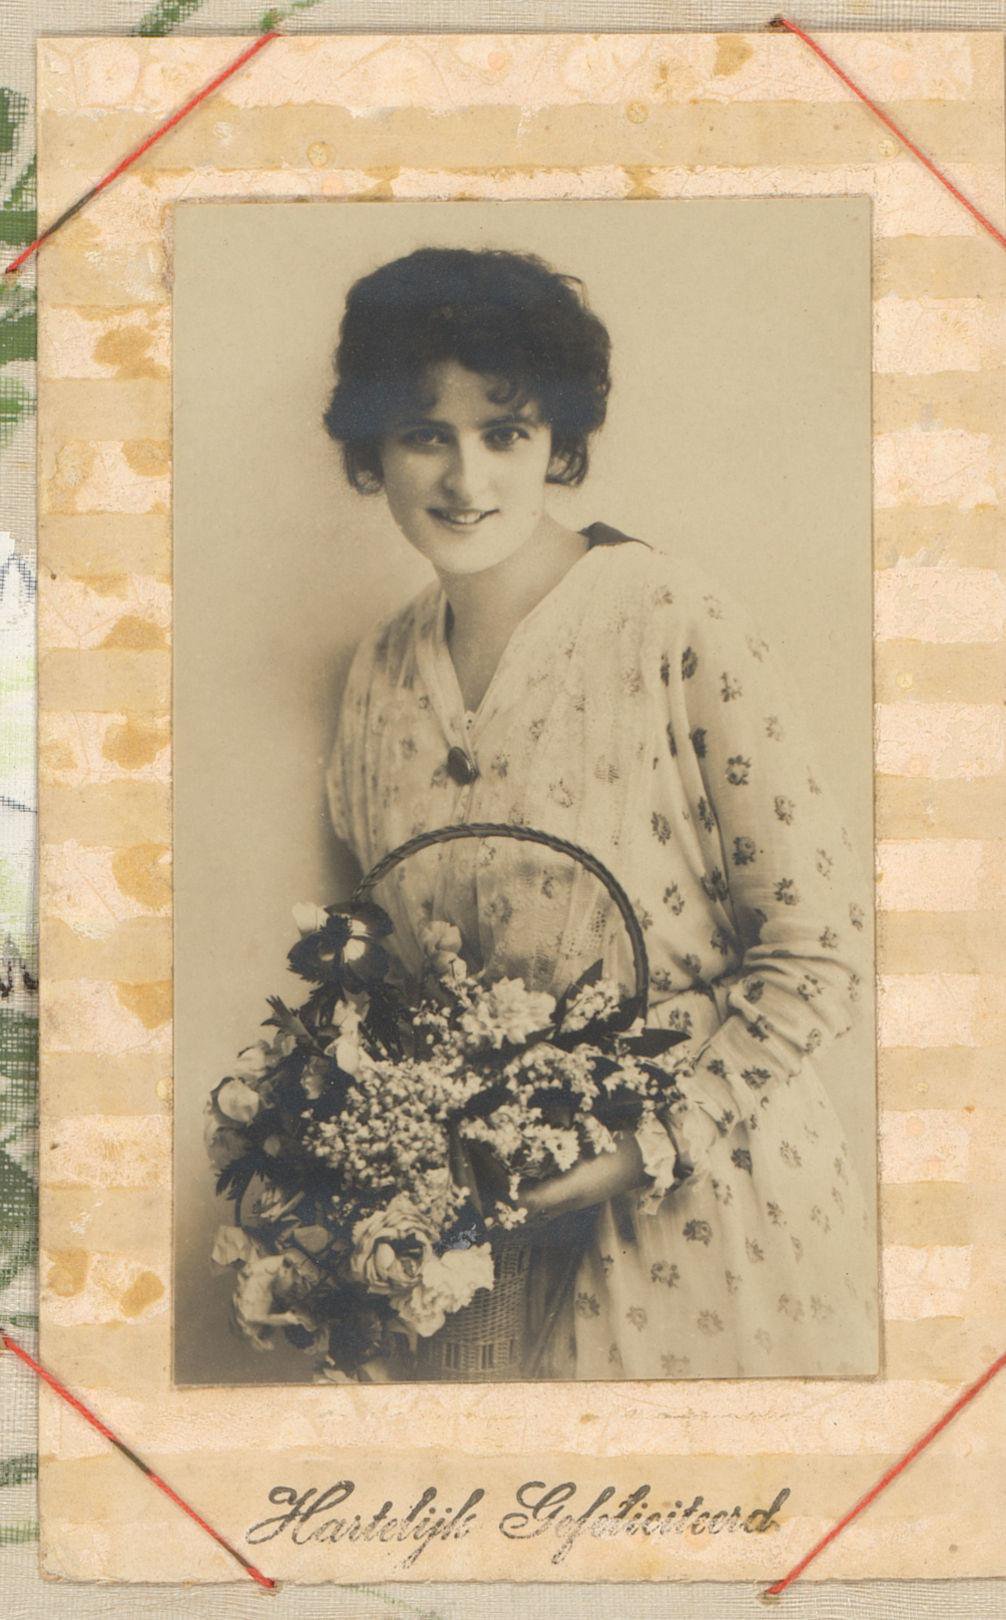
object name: album leaf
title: Portret van een vrouw met een mand bloemen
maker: Anonymous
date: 1880-1920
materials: paint, photographic support, silk, textile, watercolor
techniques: brush, gelatin silver print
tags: flowers, adult woman, historical persons, container made of plant material other than wood: basket